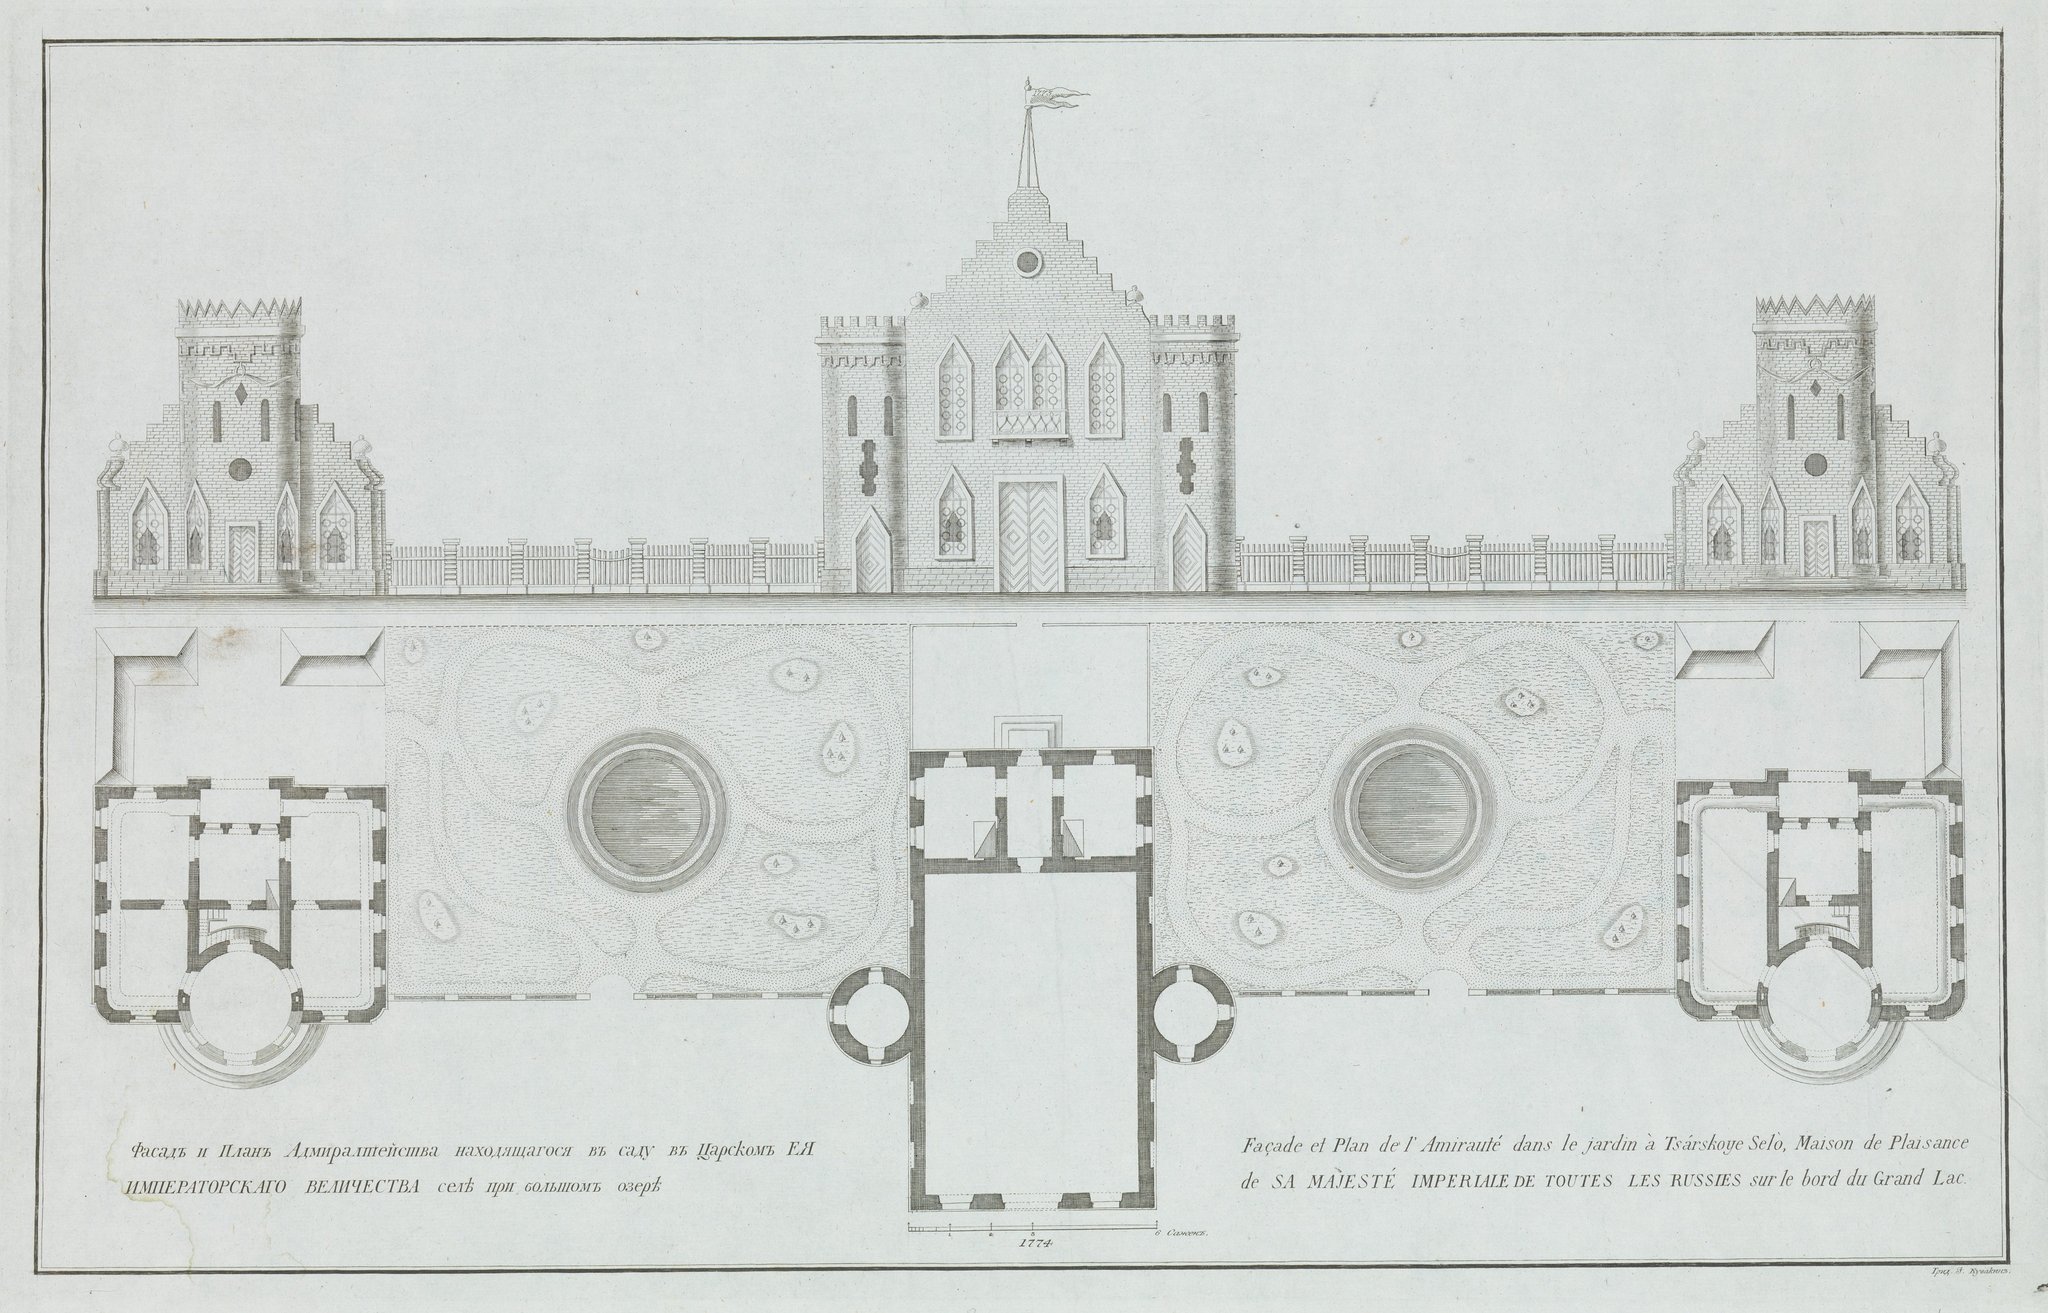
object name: print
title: Façade et plan de l'Amirauté dans le jardin à Tsárskoye Selò...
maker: ivan kuvakin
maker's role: artist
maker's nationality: russian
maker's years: 1751-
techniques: engraving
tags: architecture,buildings,gardens